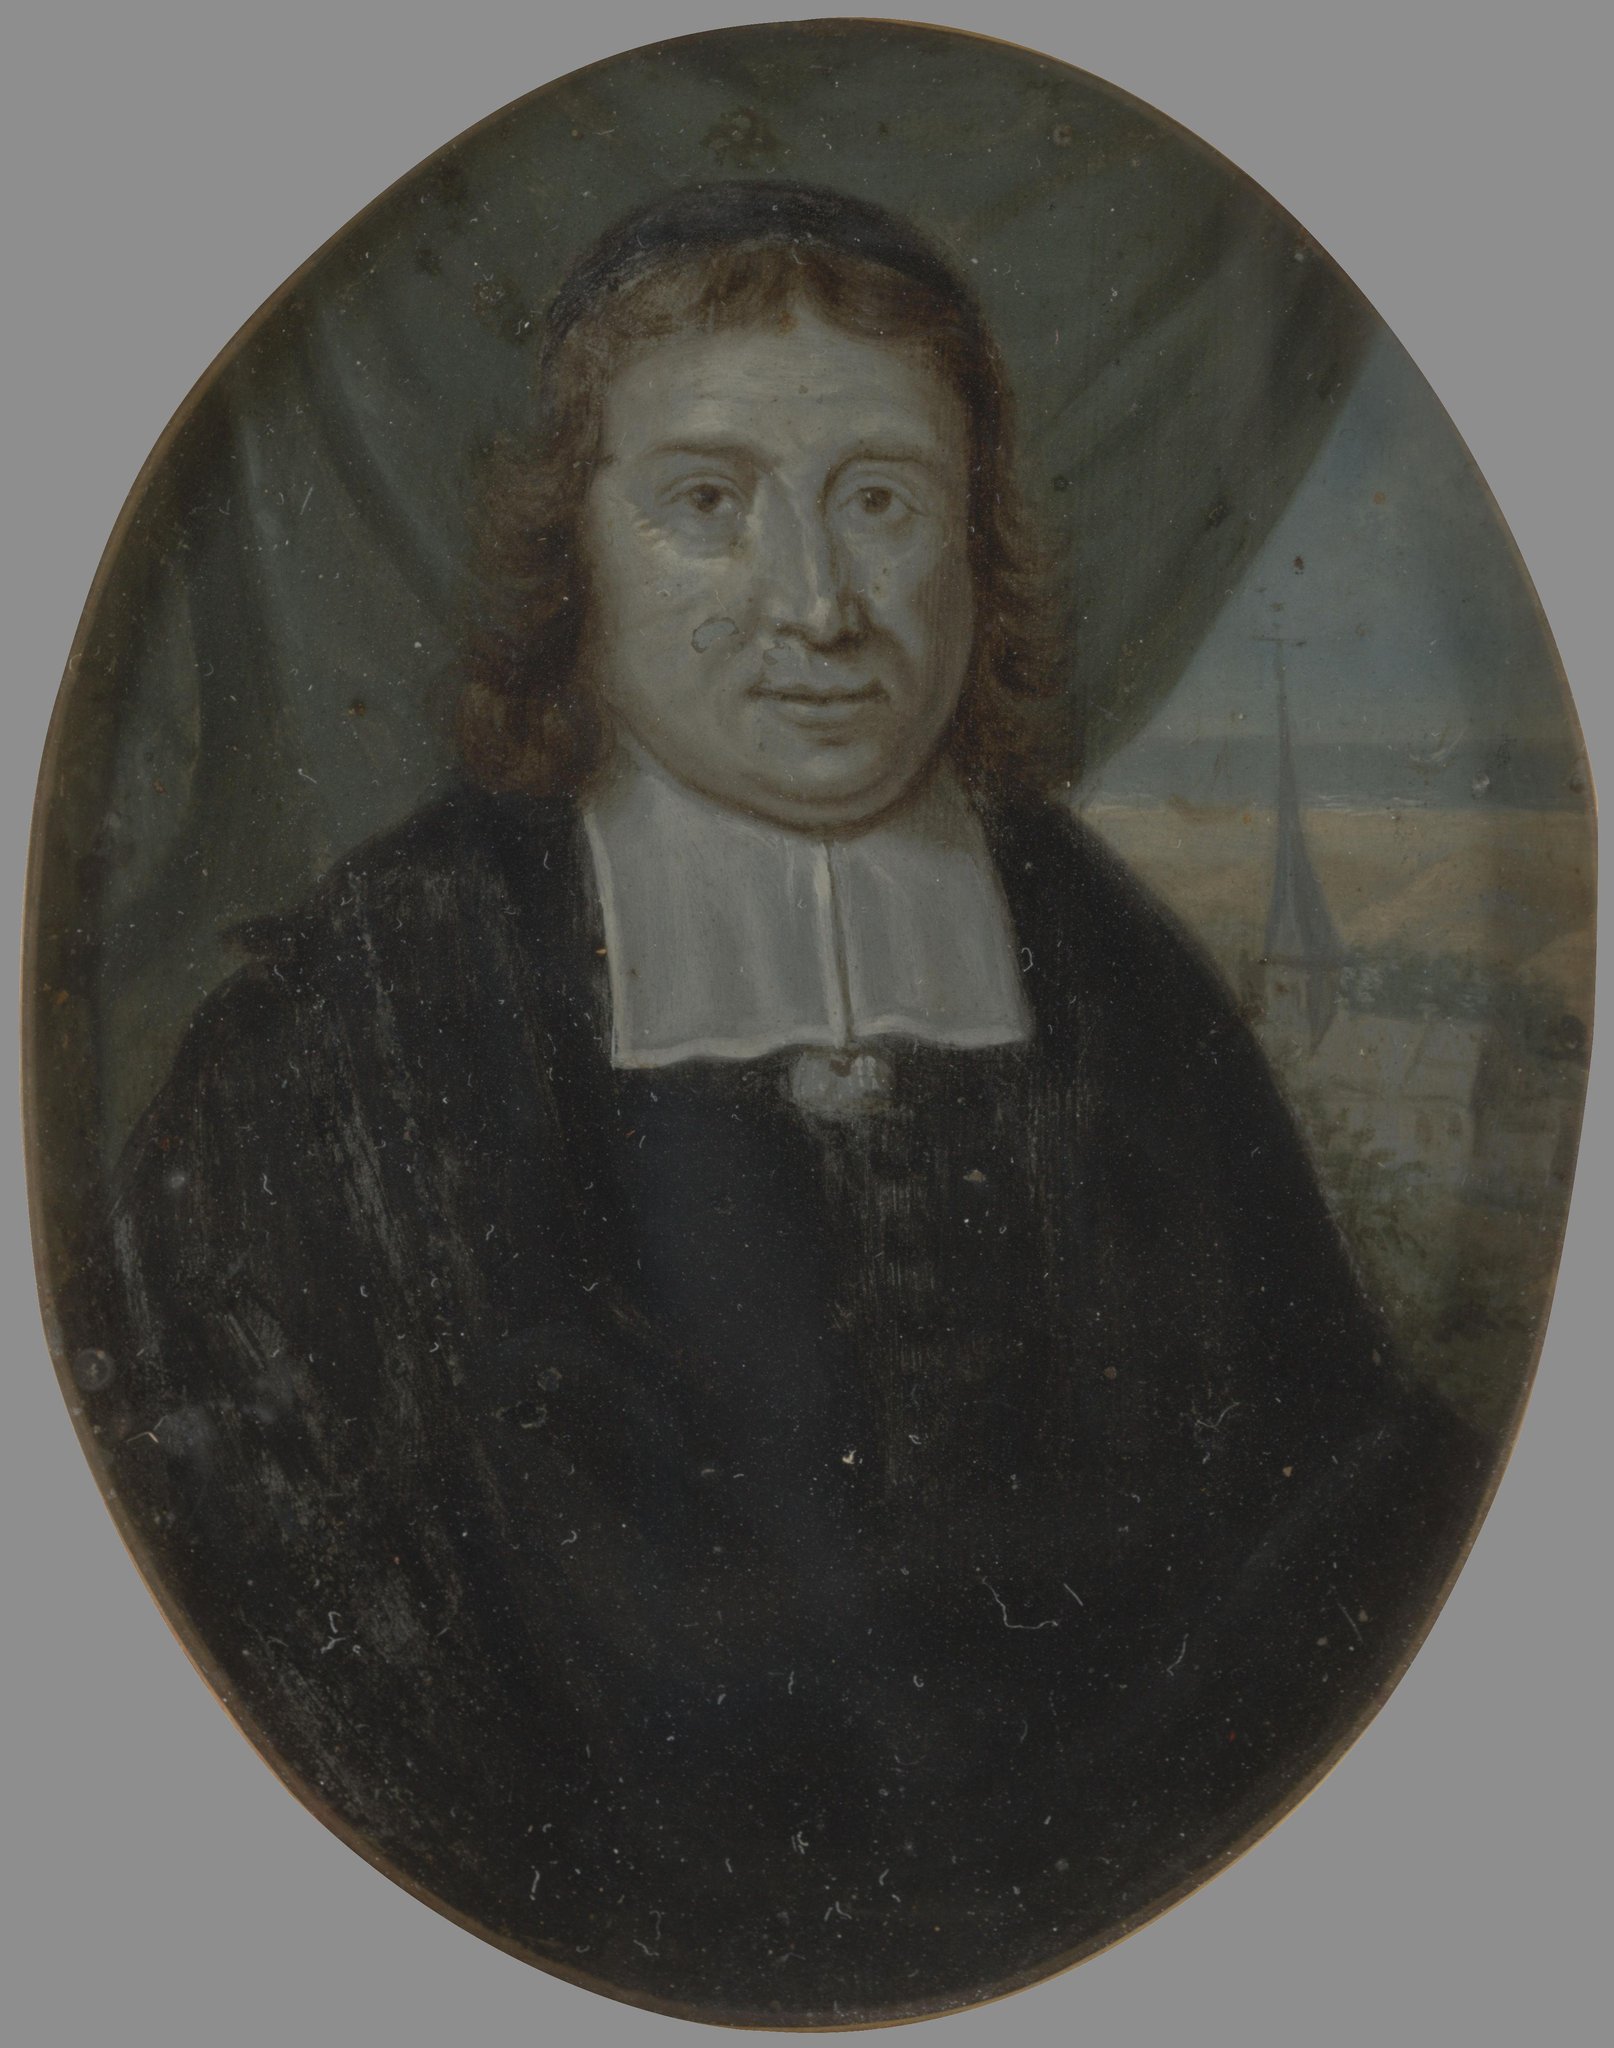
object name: painting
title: Portret van Adriaan Pars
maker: arnoud van halen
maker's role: draughtsman, painter, print maker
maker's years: 1673-1732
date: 1700-1720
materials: iron, oil, paint, zinc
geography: amsterdam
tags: the hague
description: Portret van de predikant en schrijver Adriaan Pars (Den Haag 1641-1719 Katwijk). Buste in ovaal, naar rechts. In de achtergrond een doorkijkje naar een kustplaats met een kerk. Onderdeel van het Panpoëticon Batâvum, een verzameling portretten van Nederlandse dichters.